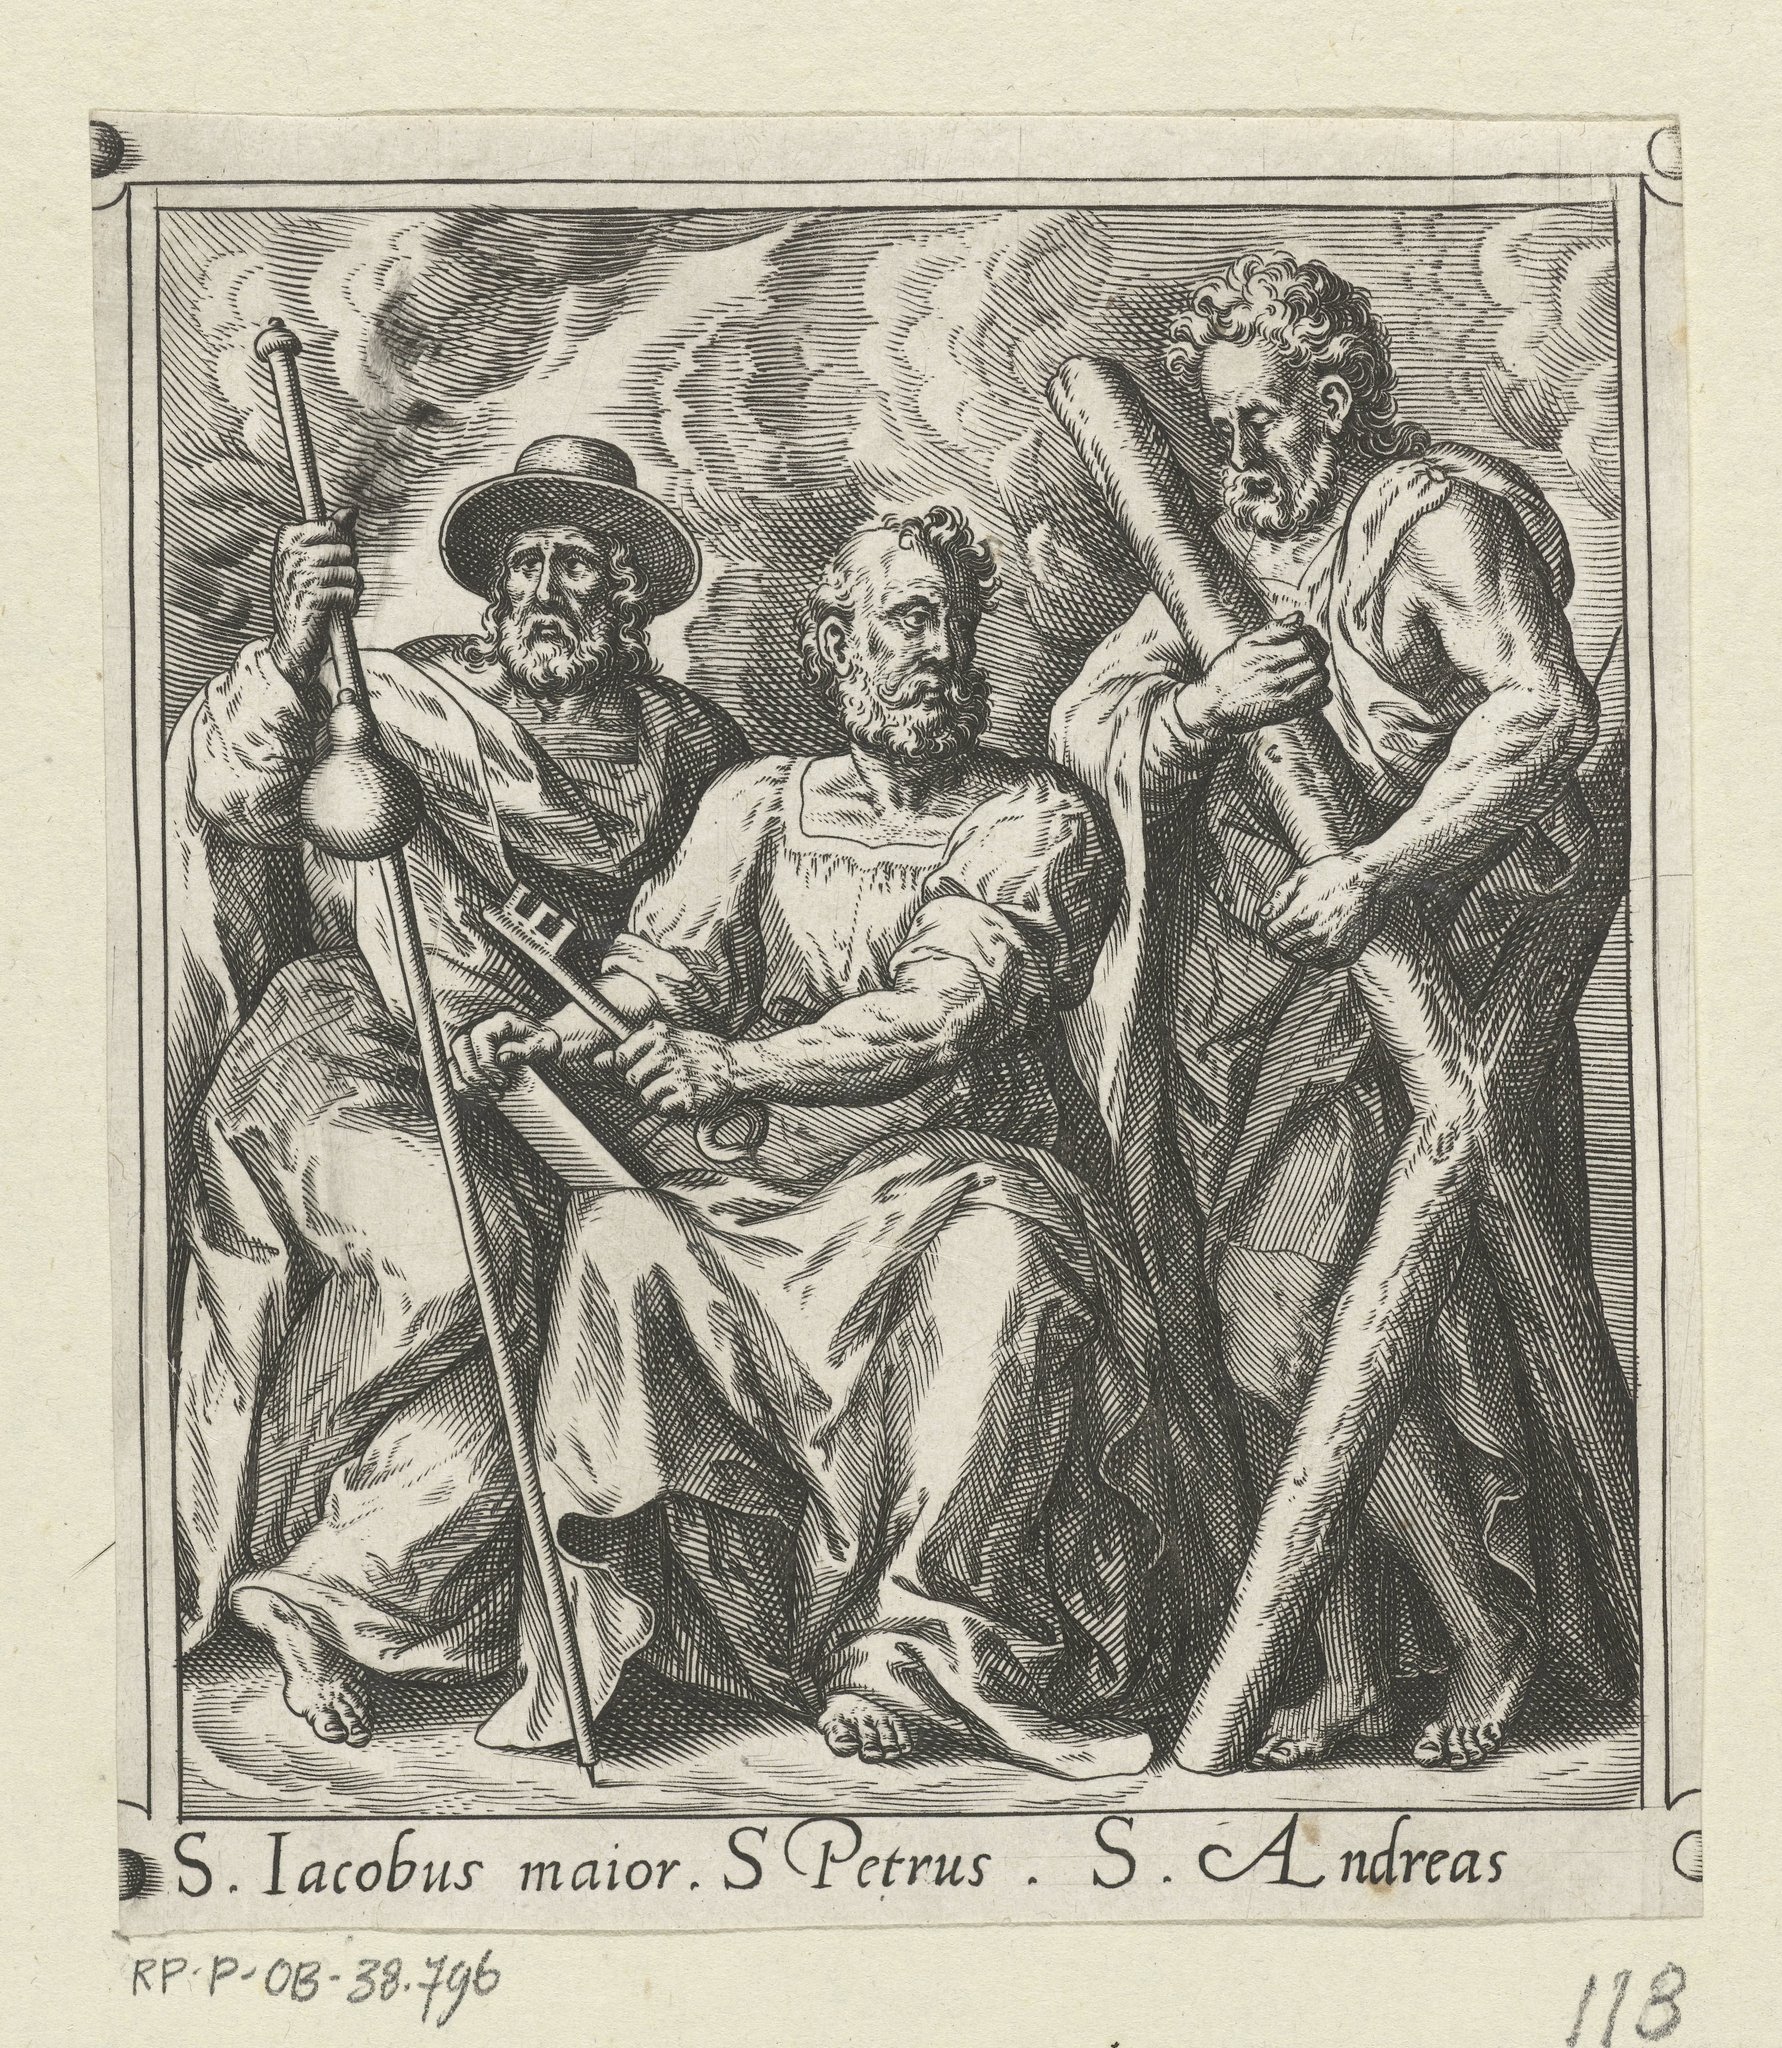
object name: print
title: S. Iacobus maior S Petrus S. Andreas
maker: Anonymous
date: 1534-1640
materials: paper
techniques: engraving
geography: italy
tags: the apostle andrew; possible attributes: book, x-shaped cross, fish, fishing-net, rope, scroll, the apostle james the great; possible attributes: book, pilgrim's cloak, hat, shell, staff, and wallet, scroll, sword, the apostle peter, first bishop of rome; possible attributes: book, cock, (upturned) cross, (triple) crozier, fish, key, scroll, ship, tiara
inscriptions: collector's mark: Lugt 240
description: Prent naar ontwerp van Crispijn van den Broeck.